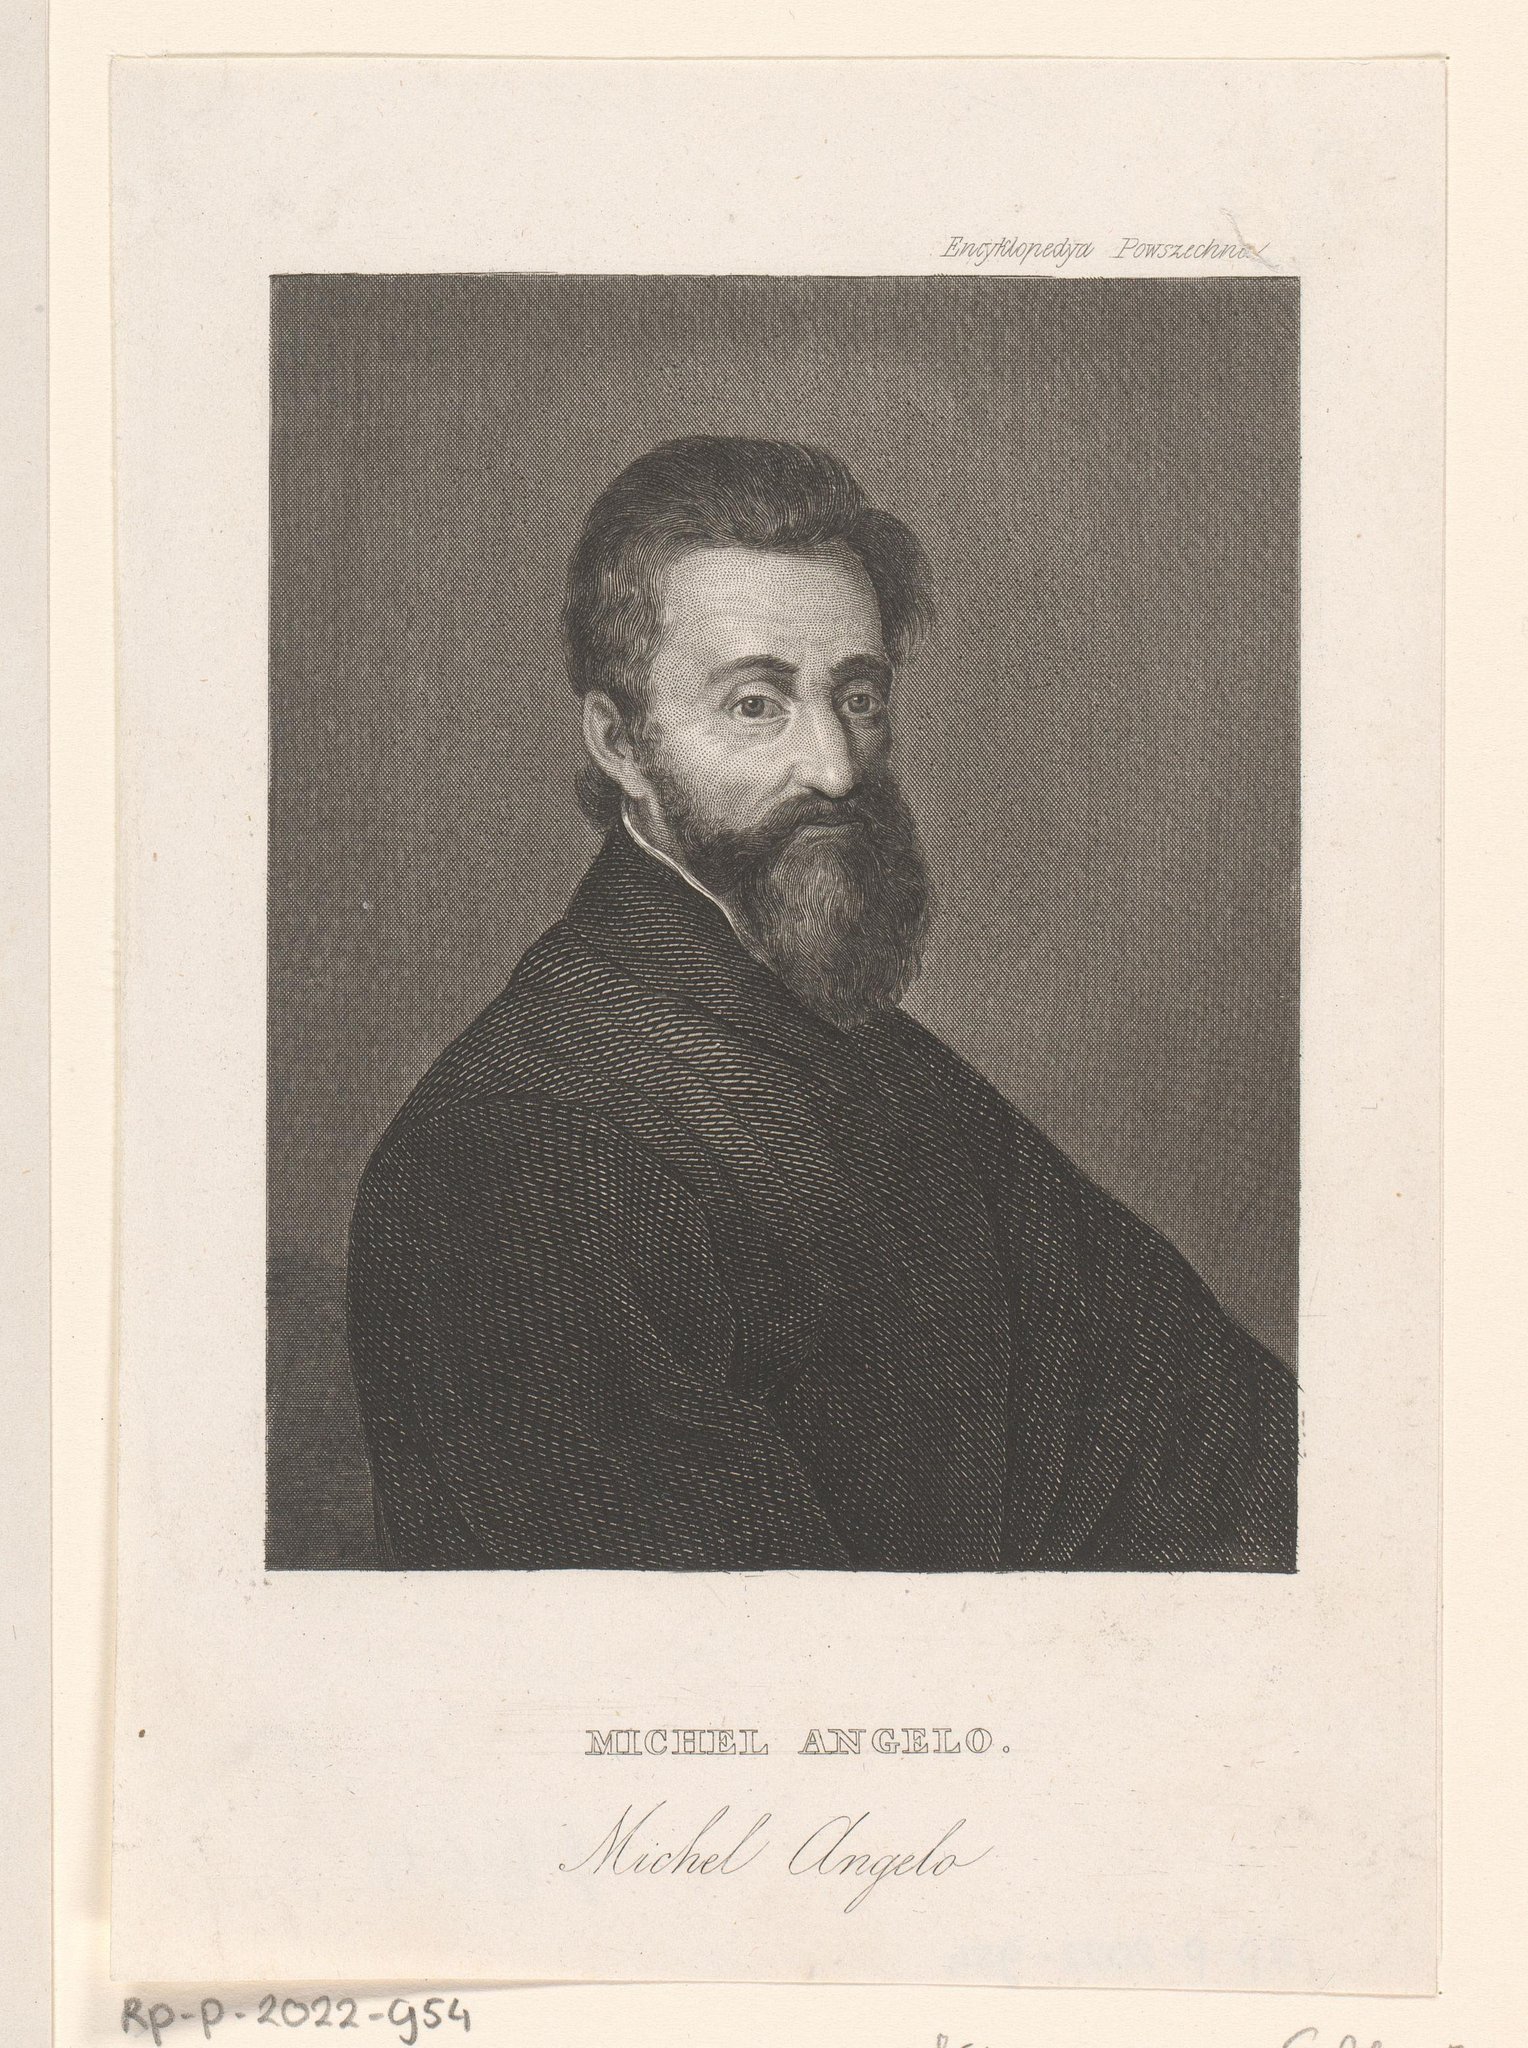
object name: book illustration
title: Portret van Michelangelo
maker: Anonymous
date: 1859-1868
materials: paper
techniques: engraving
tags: rome, painter, draughtsman, sculptor, michelangelo, historical persons, portrait, self-portrait of artist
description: Prent waarschijnlijk uit een deel van: Encyklopedia Powszechna. S.l.s.n, 1859-1868, 28 dl.